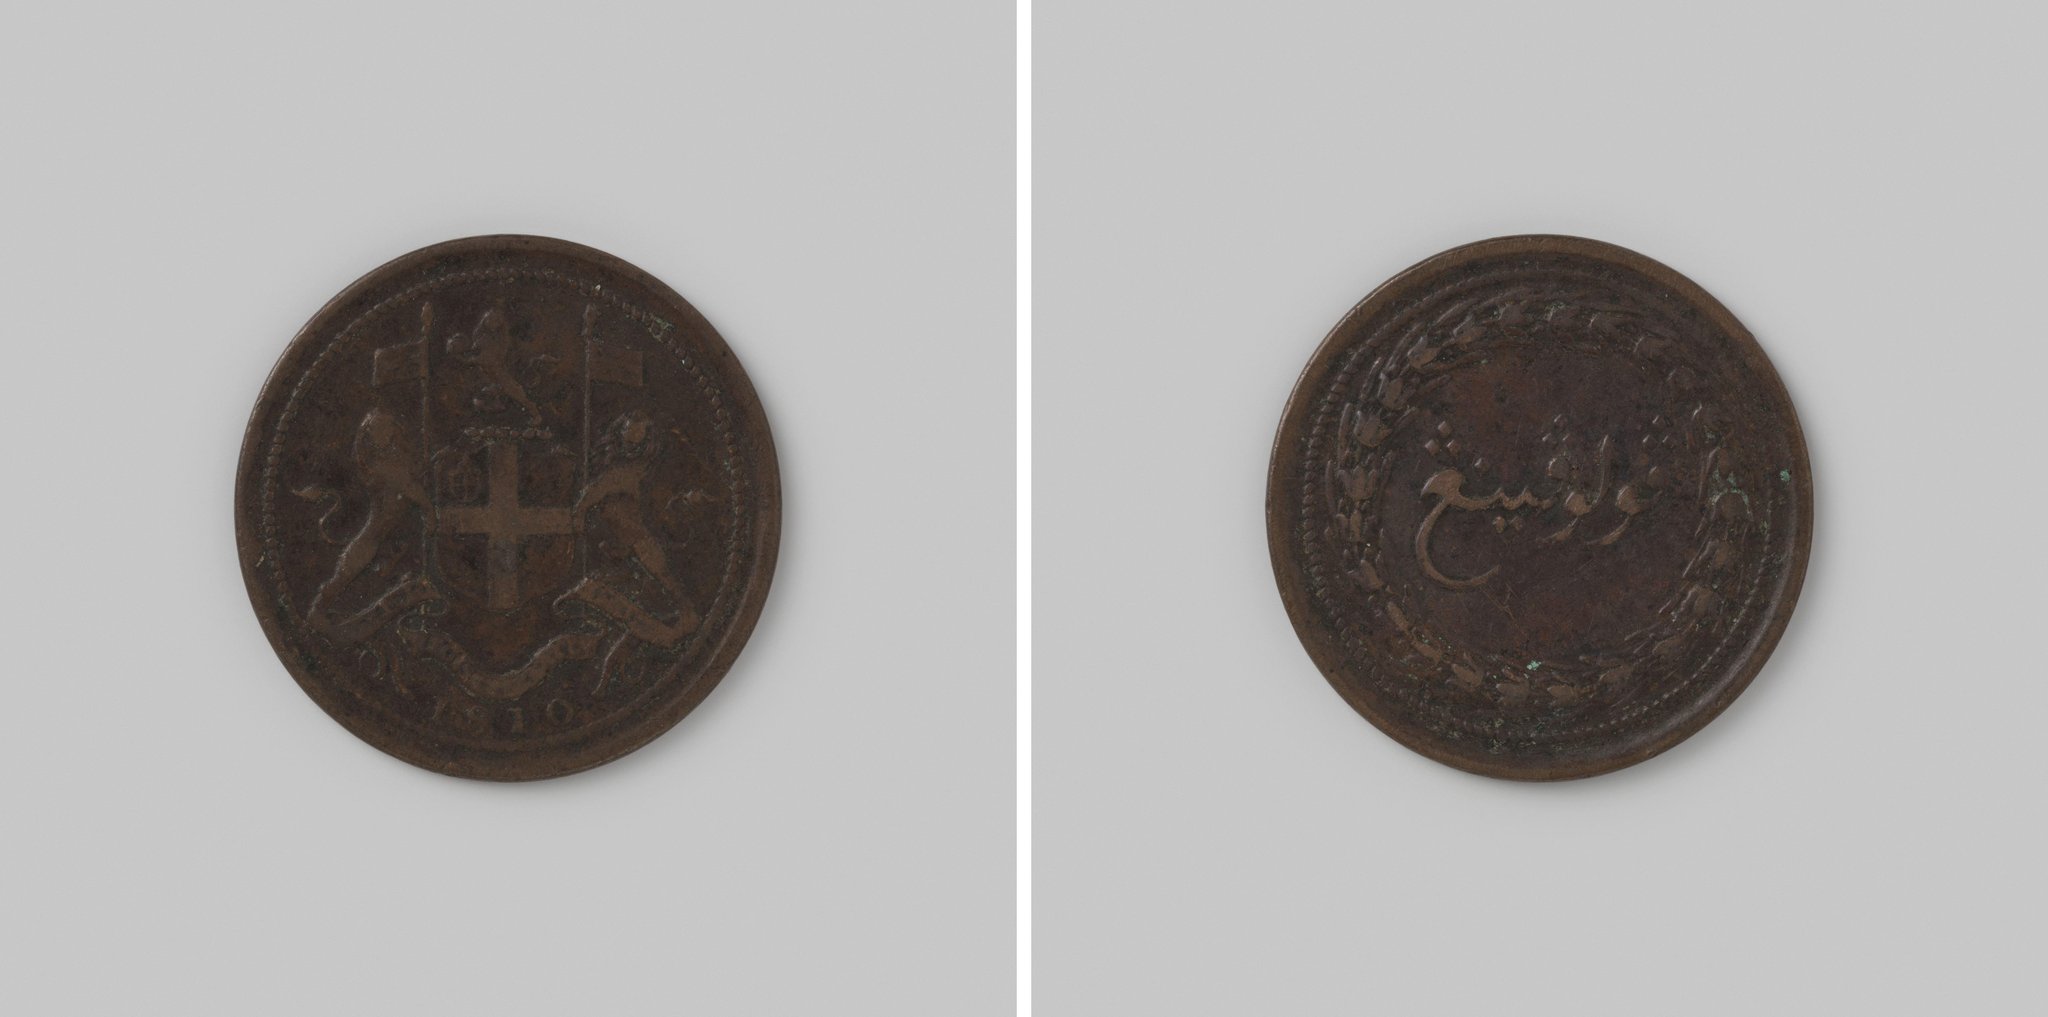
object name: coin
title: ½ cent uit Malakka, Pulu Penang, 1810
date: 1810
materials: copper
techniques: striking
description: Koperen munt. Voorzijde: door twee op banderol, waarin opschrift, staande leeuwen met pijl, waaraan vlag, in de klauw, gehouden wapenschild van de EIC, waarboven helmteken. Jaartal onderaan. Keerzijde: binnen krans van bladeren eenregelig opschrift in het Maleis in Arabische lettertekens: pulu penang.